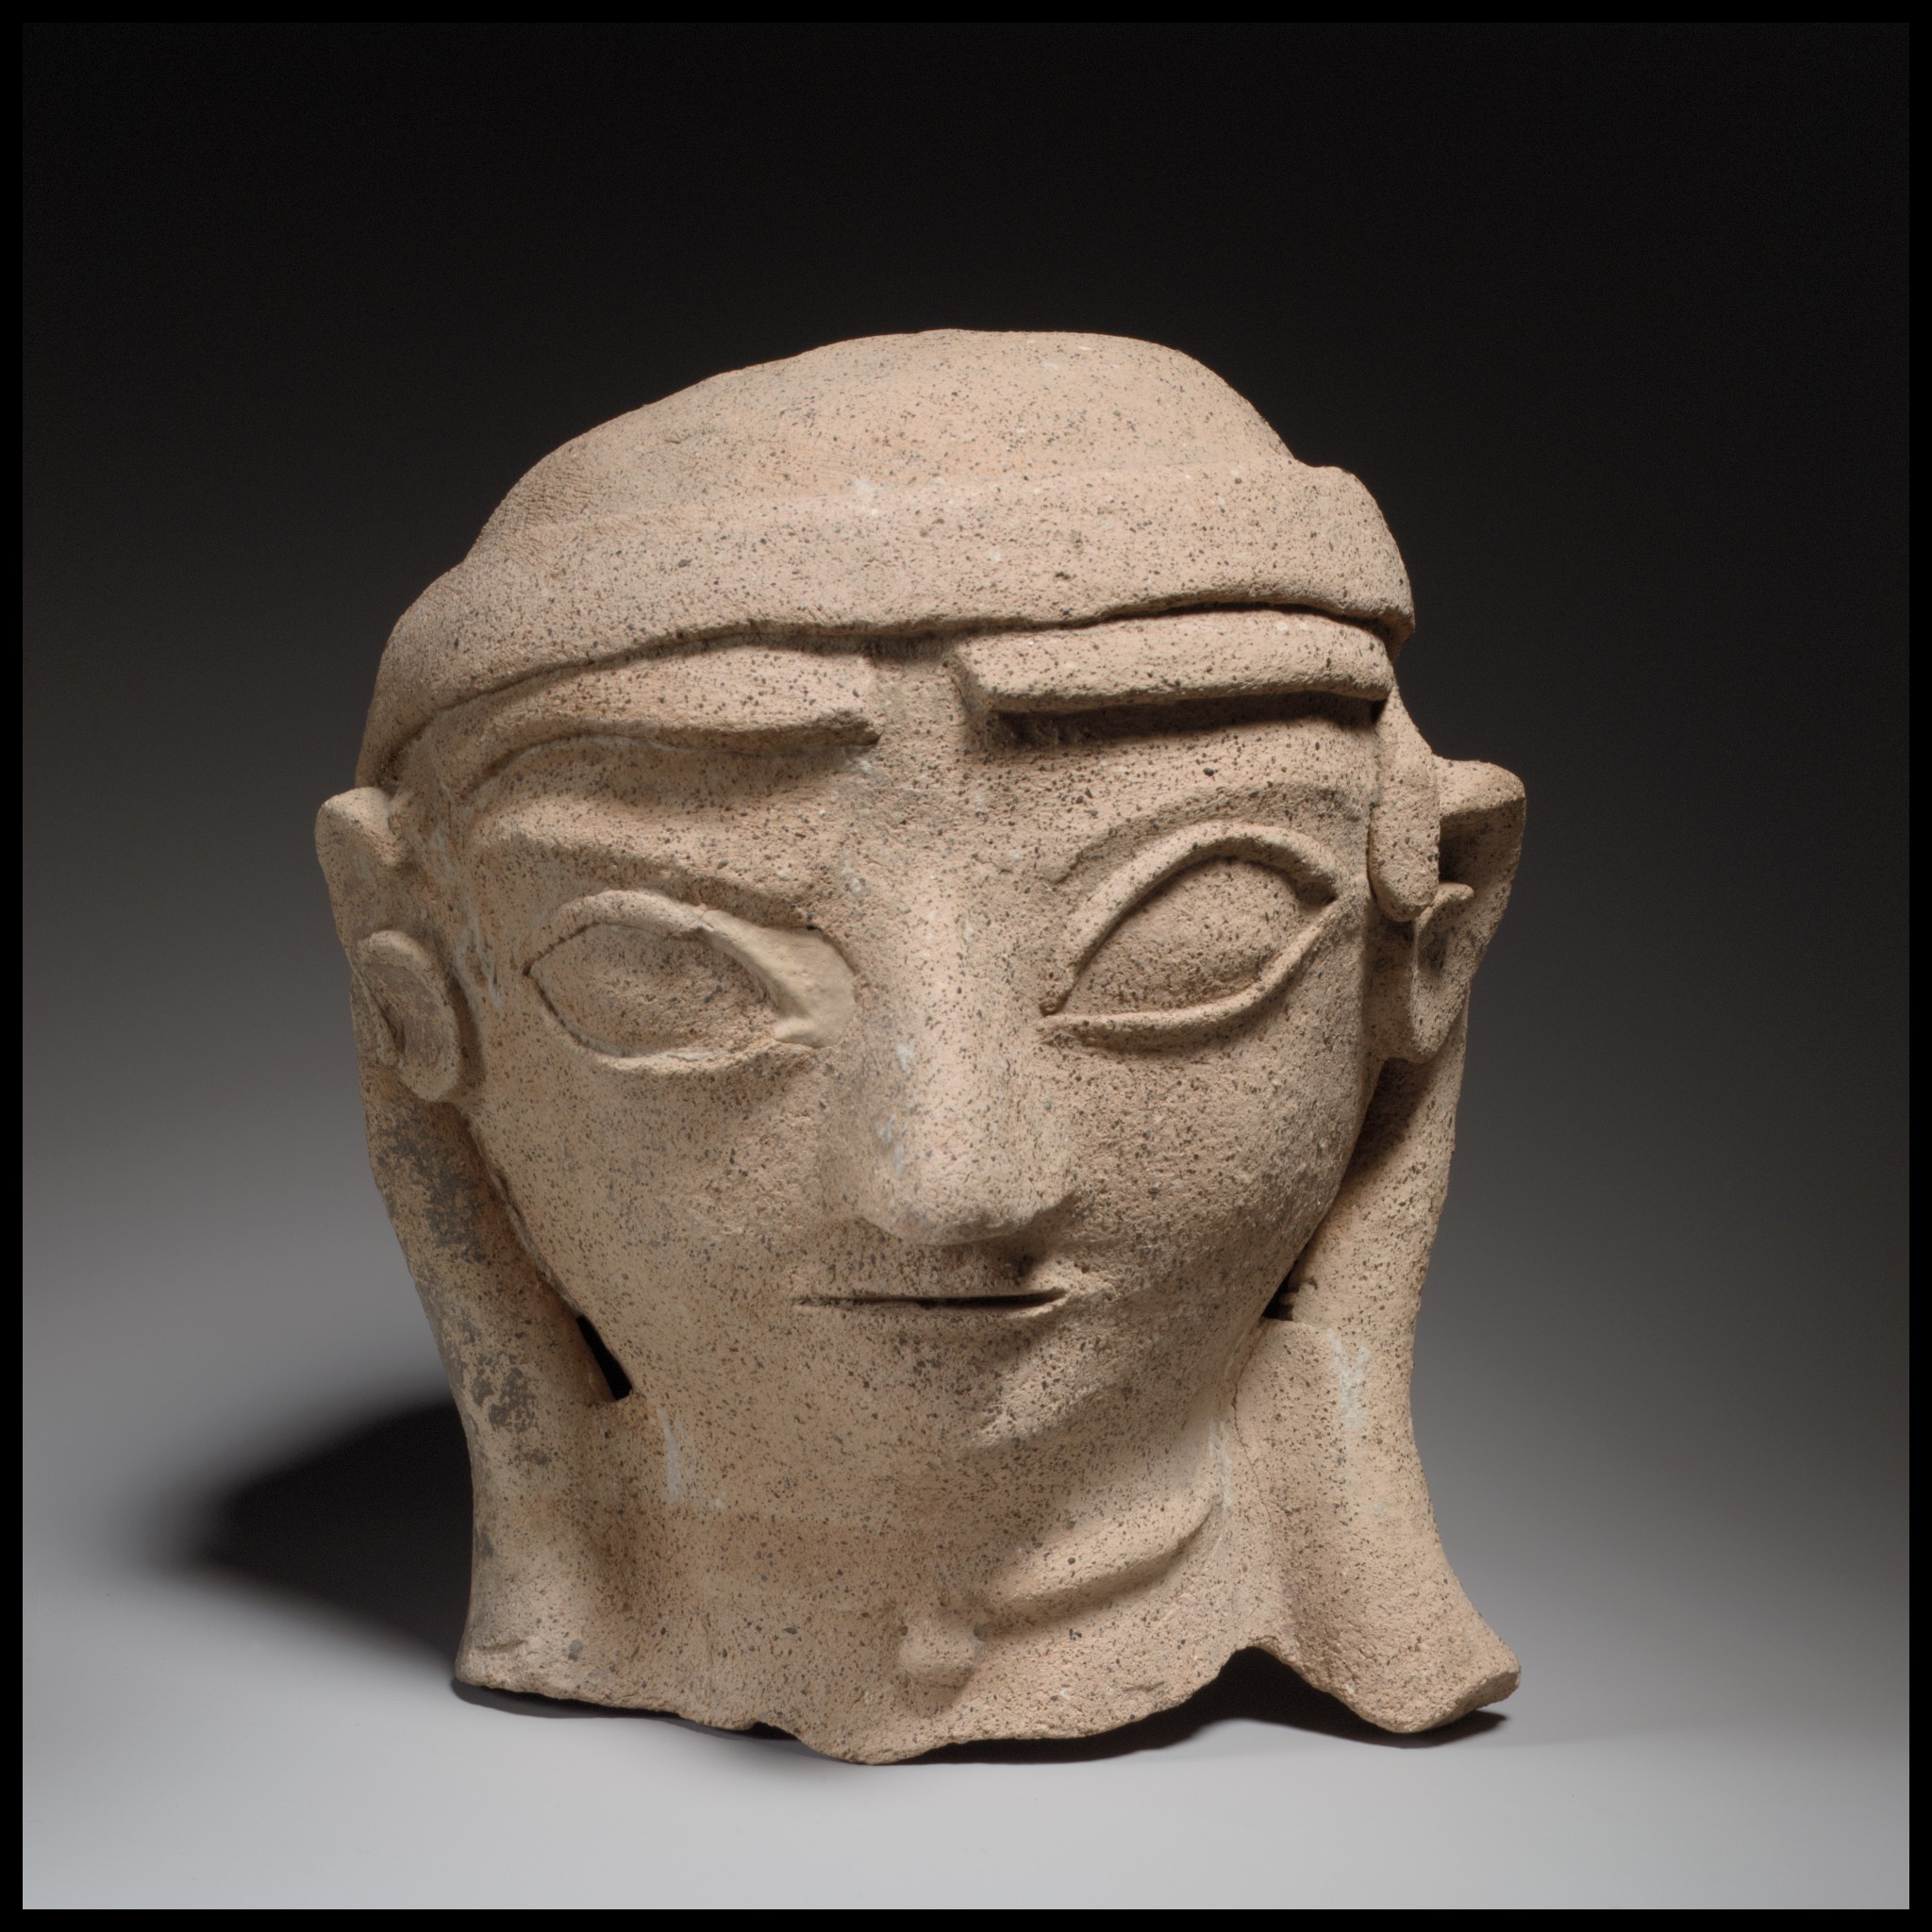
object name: head of a woman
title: Terracotta head of a woman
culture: cypriot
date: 600-501 BCE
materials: terracotta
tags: heads,women